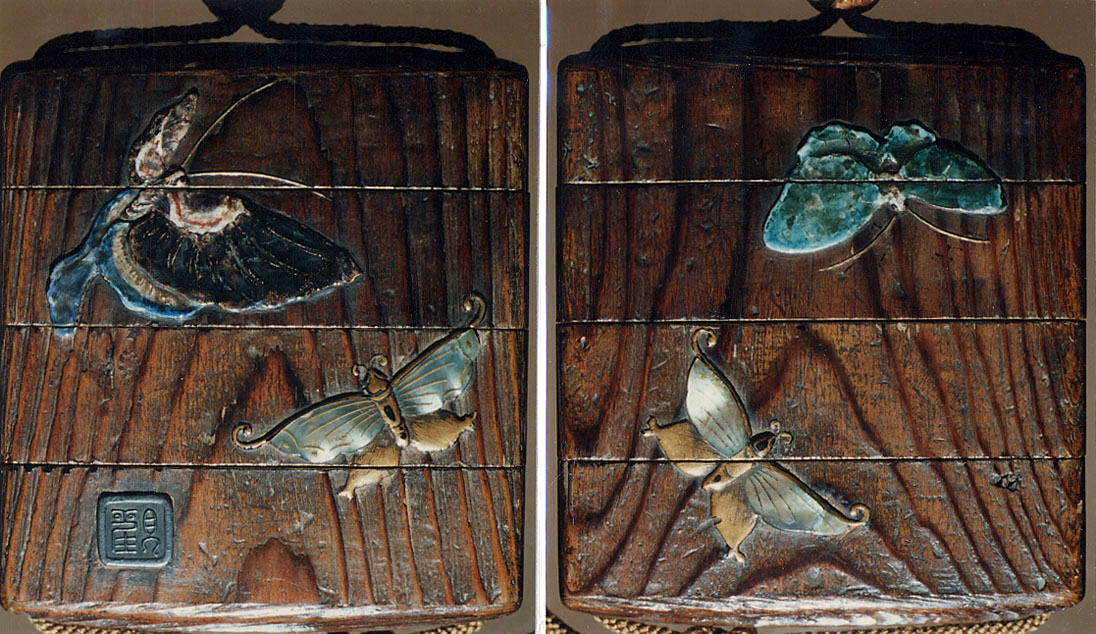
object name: inrō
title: Case (Inrō) with Design of Butterflies in Flight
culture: japanese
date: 1801-1900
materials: gold, lacquer, pottery, wood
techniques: fundame, inlay, maki-e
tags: butterflies